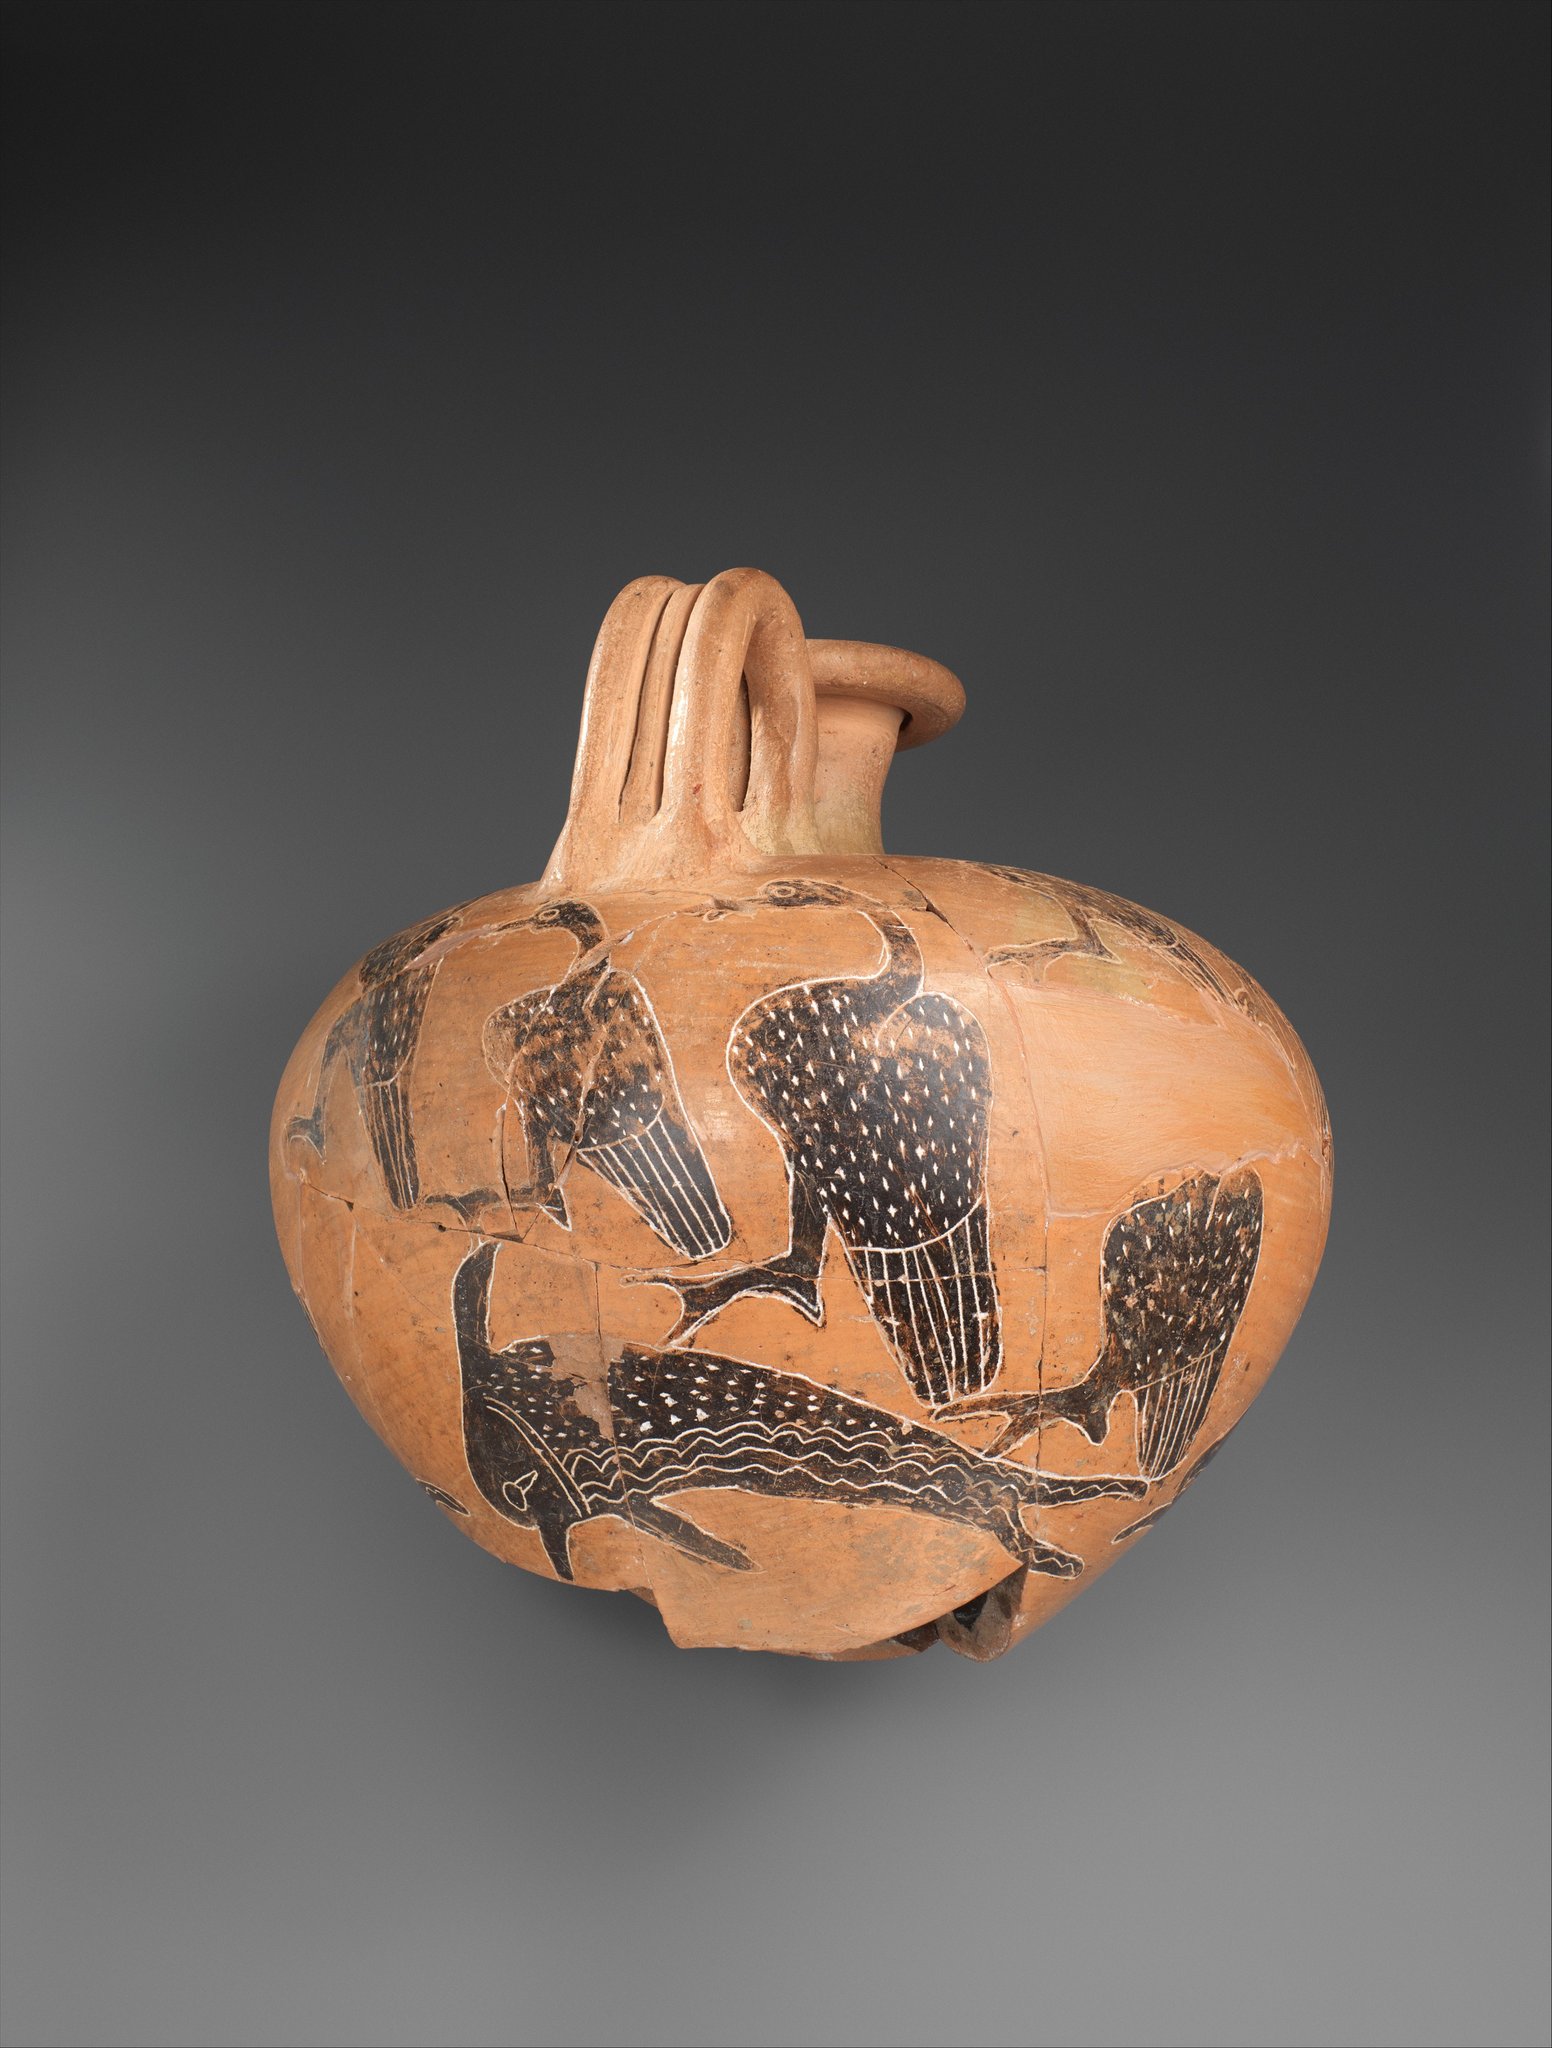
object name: jug, dolphin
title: Jug Decorated with Dolphins and Birds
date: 1750-1550 BCE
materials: gypsum, pottery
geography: egypt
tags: birds,dolphins